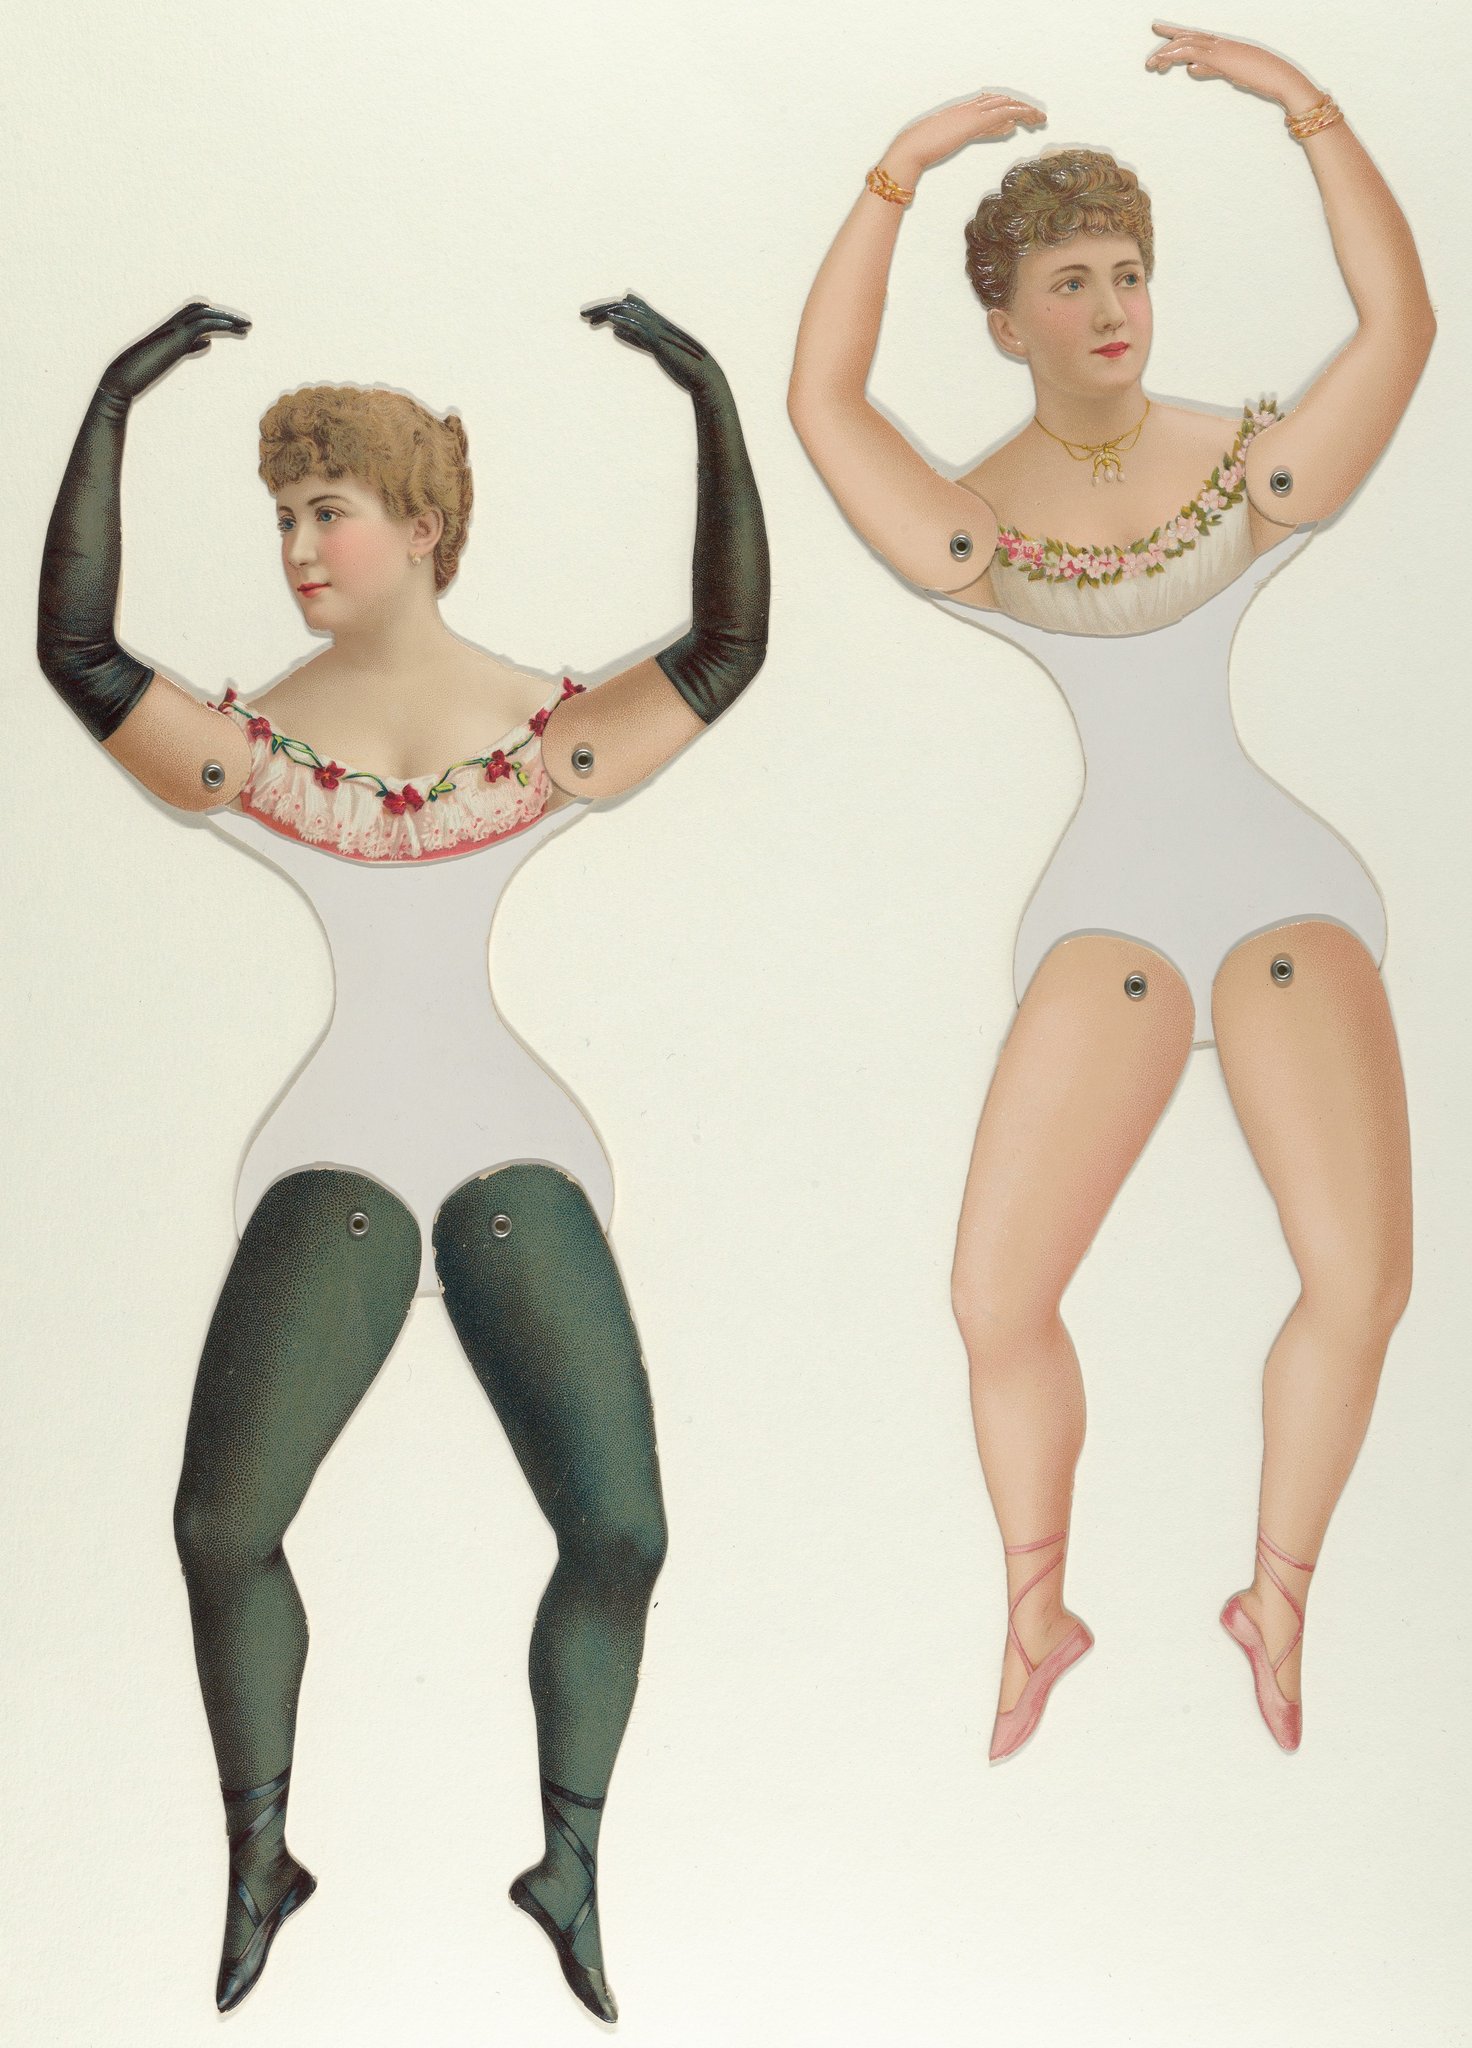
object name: print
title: Ballerina and Bloomer Girls (Prima Donna) Paper Dolls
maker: littauer and boysen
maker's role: publisher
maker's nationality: german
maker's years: 1850-1900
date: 1890-1905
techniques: lithograph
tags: women,dolls